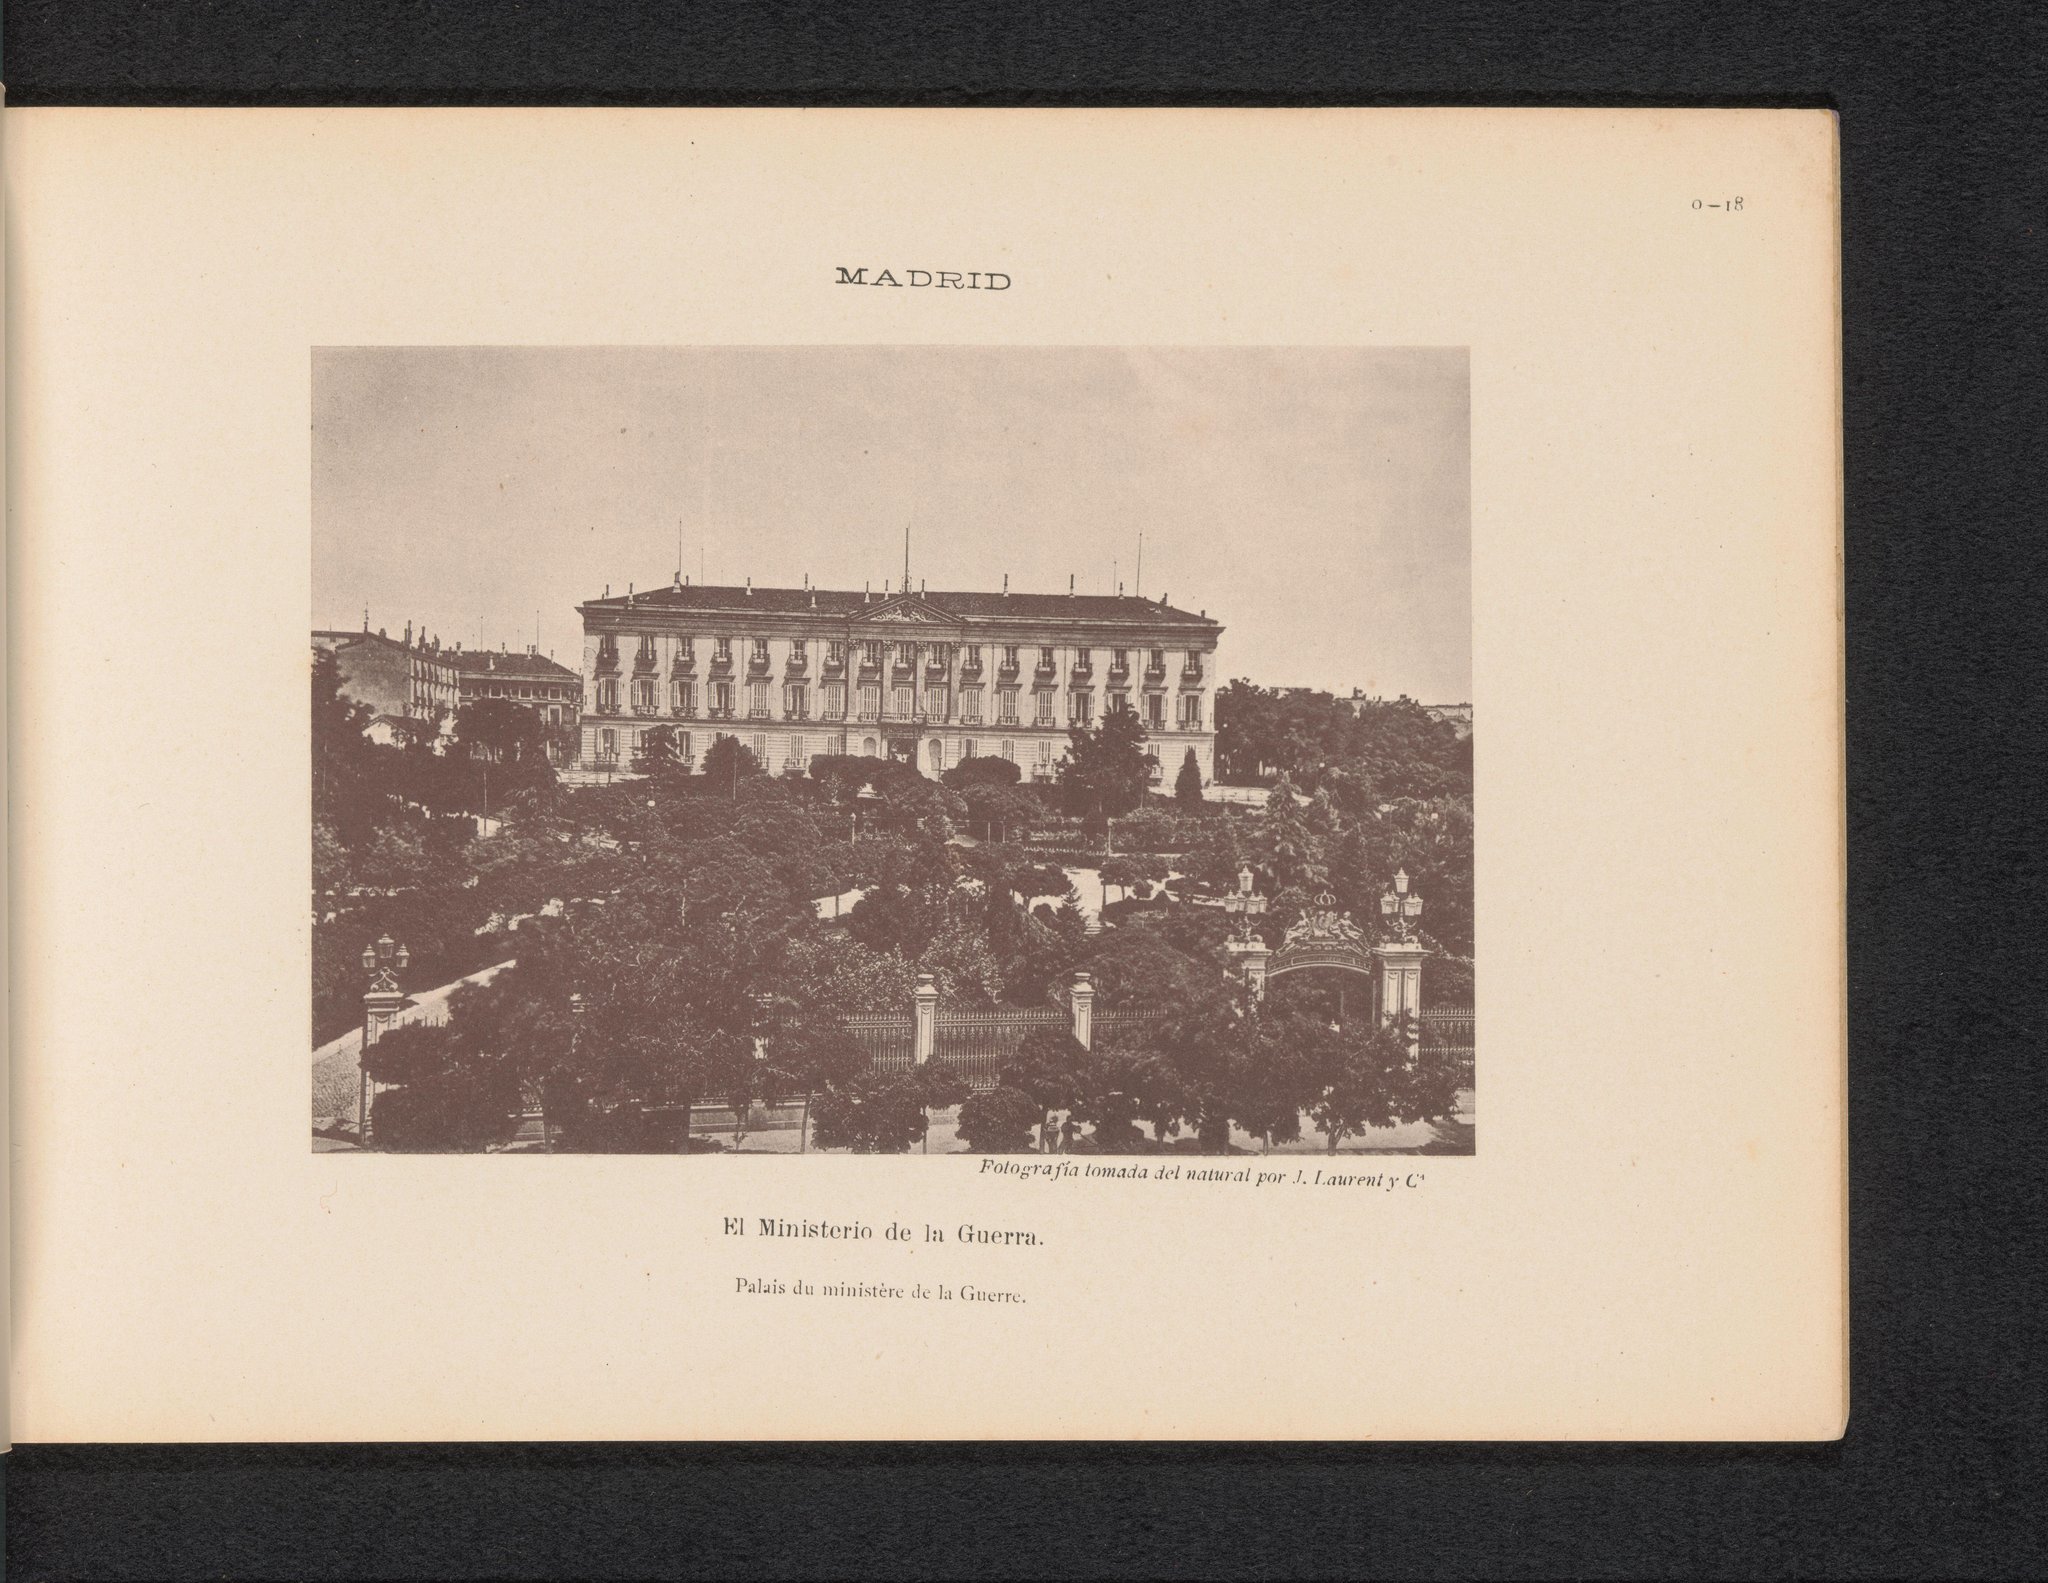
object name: page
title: Gezicht op ministerie van oorlog in het Palacio de Buenavista in Madrid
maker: juan laurent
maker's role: publisher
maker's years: 1816-1896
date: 1880-1890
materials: paper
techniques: photograph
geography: madrid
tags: palace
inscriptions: number: ‘0-18’